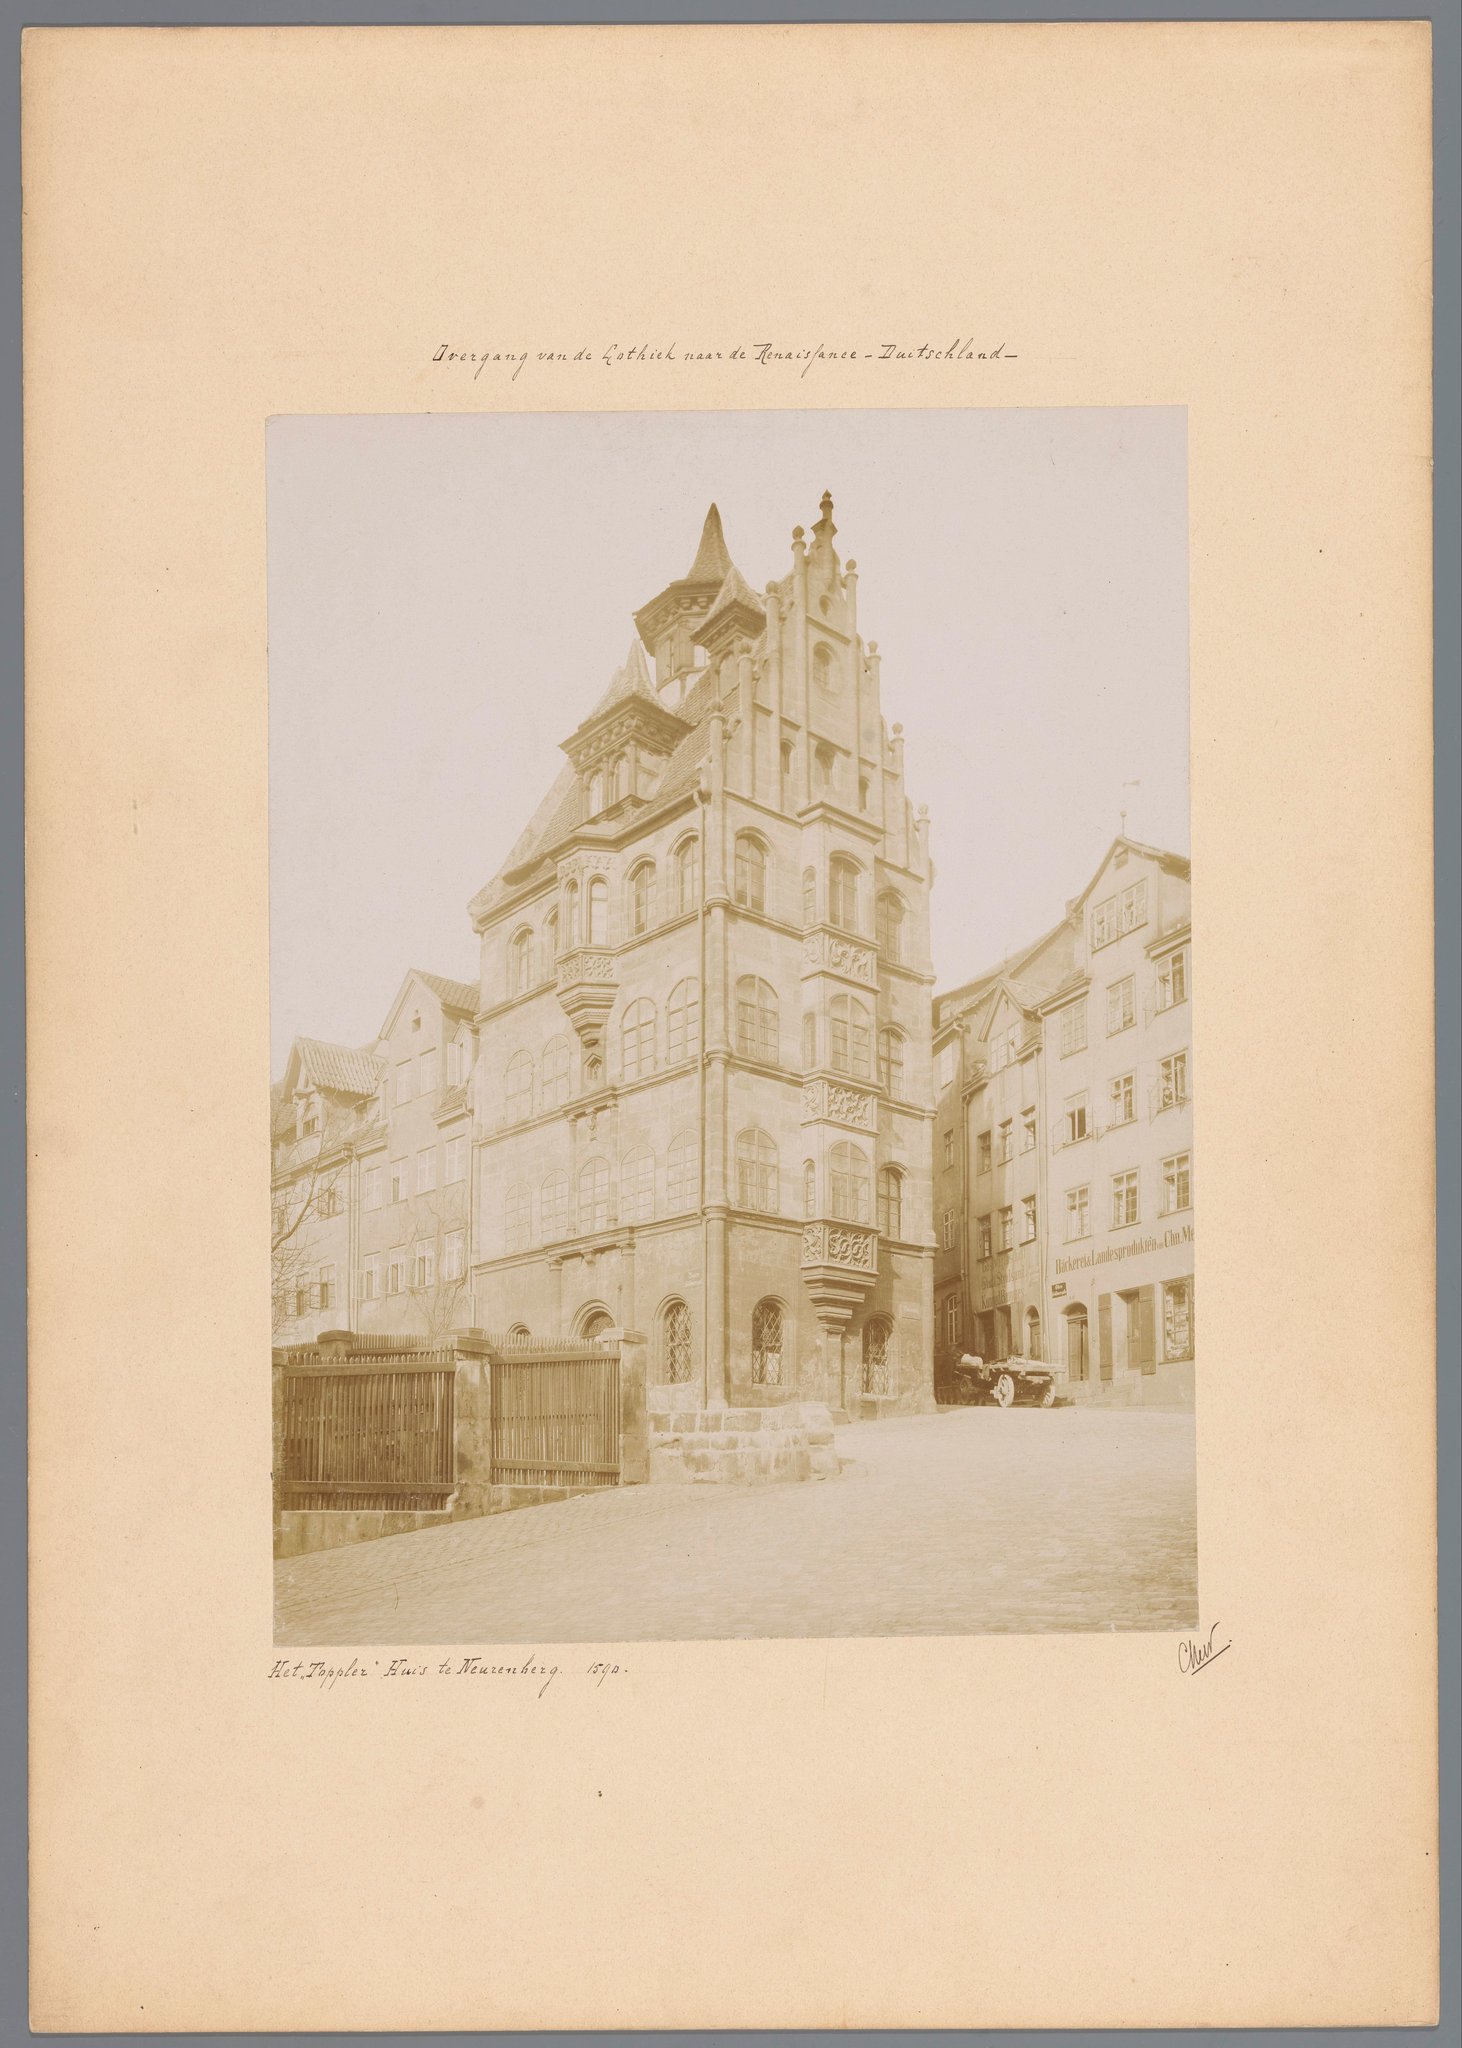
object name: photograph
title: Het ,,Toppler" Huis te Neurenberg.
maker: Anonymous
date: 1875-1900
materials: cardboard, photographic support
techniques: collodion silver print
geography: nuremberg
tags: urban housing, fence, wall, paling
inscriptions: collector's mark: ‘KUNSTNIJVERHEIDSCHOOL QUELLINUS AMSTERDAM FRANS HALSSTRAAT 14.’, inscription: ‘CWN.’, collector's mark: ‘INSTITUUT VOOR KUNST-NIJVERHEIDSONDERWIJS GABRIËL METSUSTRAAT No. 16 AMSTERDAM’, inscription: ‘Overgang van de Gothiek naar de Renaissance - Duitschland.’